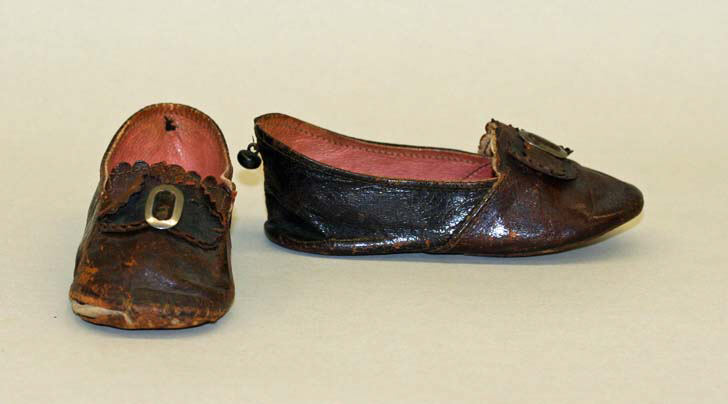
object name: slipper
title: Slippers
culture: american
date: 1870-1880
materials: leather